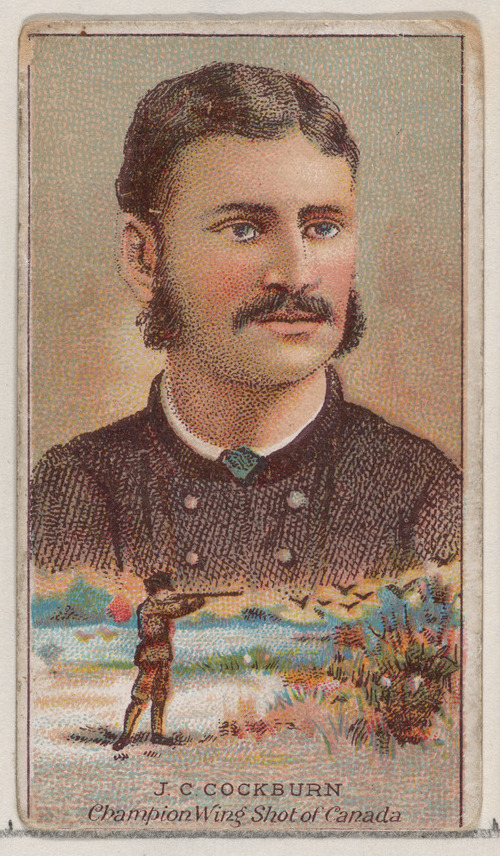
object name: print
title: J.C. Cockburn, Champion Wing Shot of Canada, from the Champions of Games and Sports series (N184, Type 2) issued by W.S. Kimball & Co.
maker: w.s. kimball & co.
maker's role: publisher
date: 1887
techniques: color lithograph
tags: men,sports,athletes